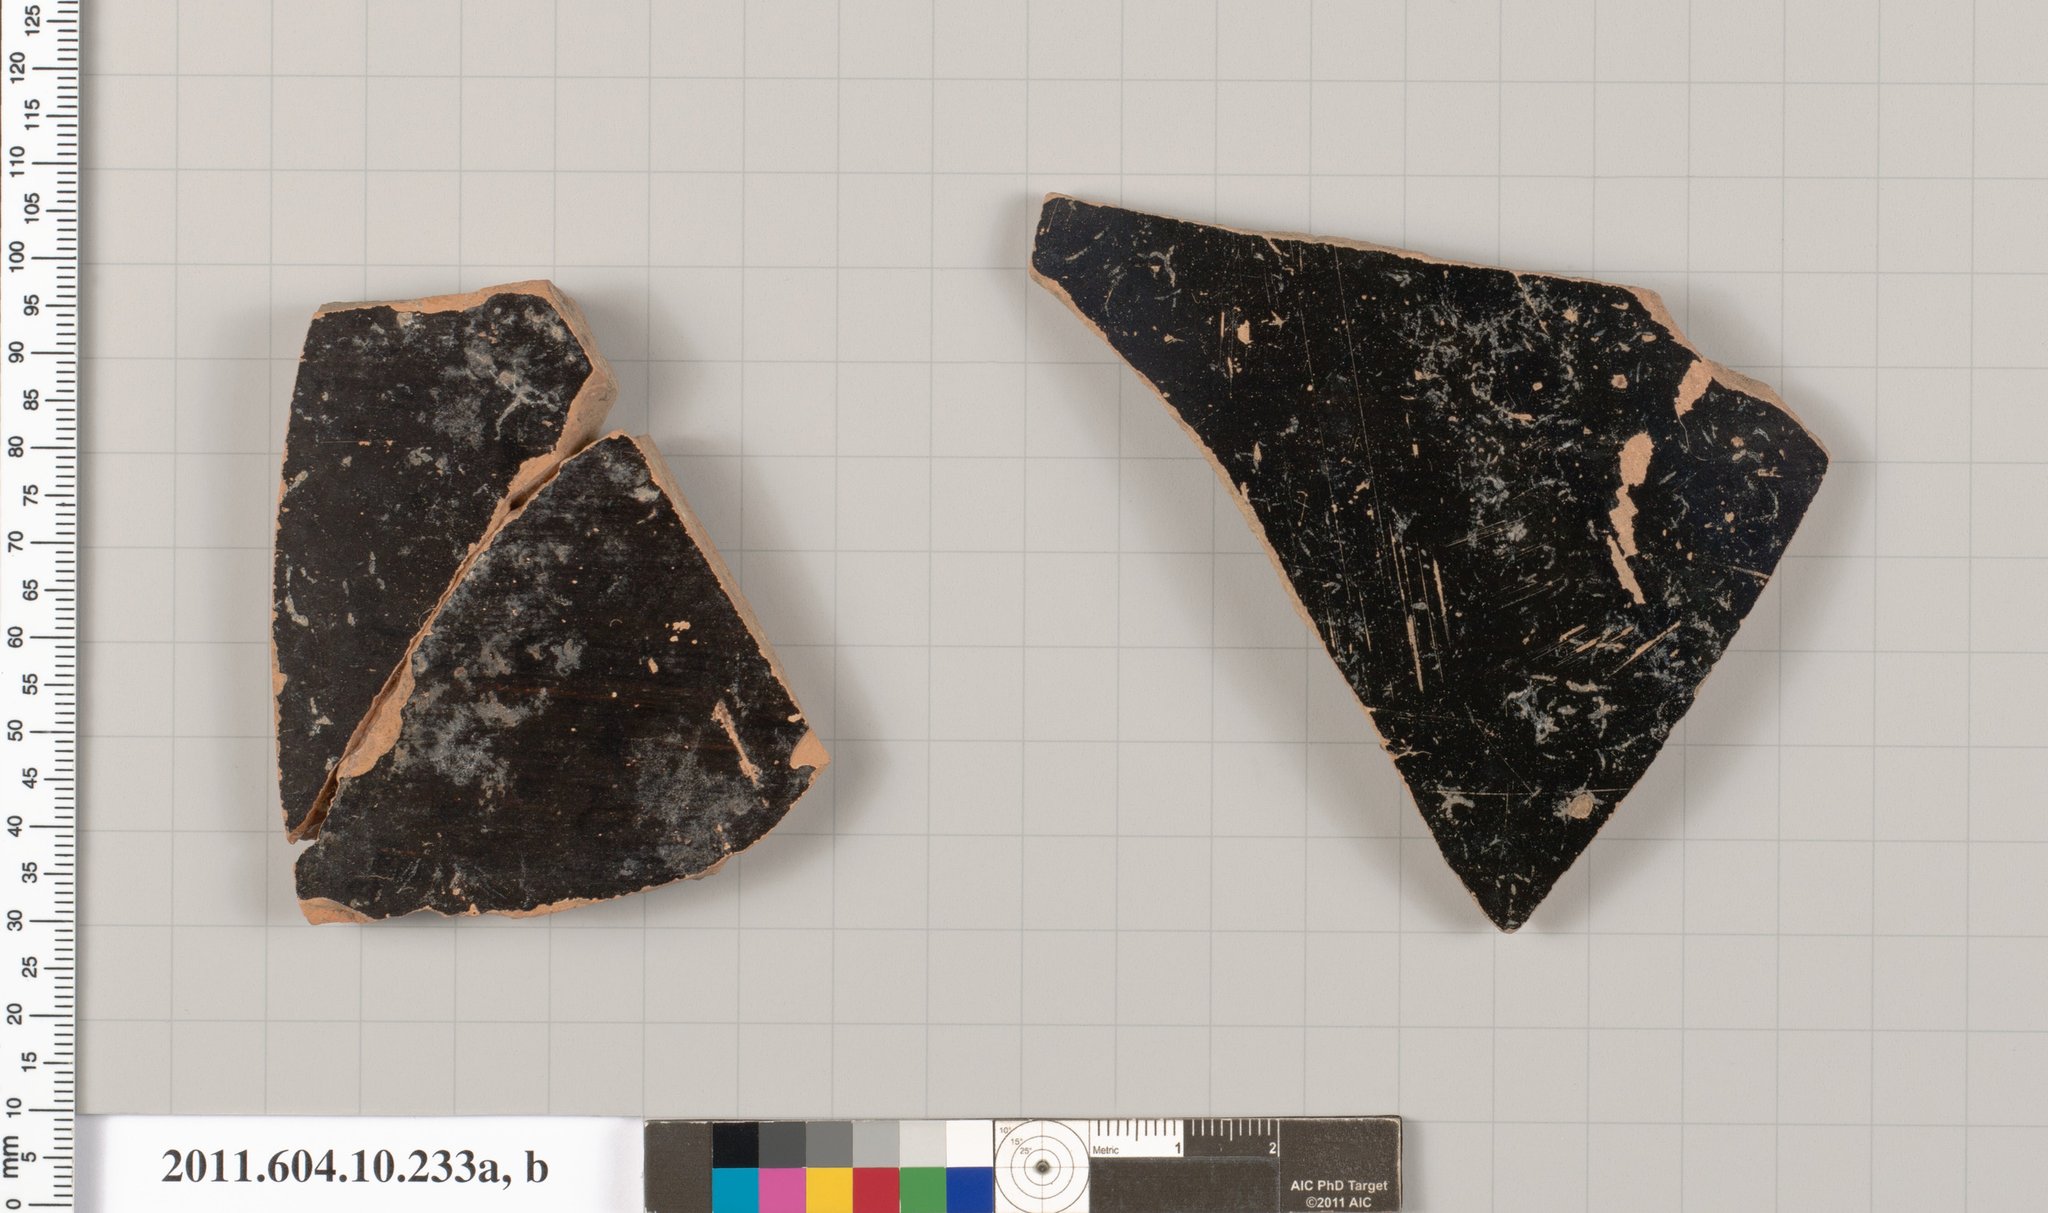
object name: krater fragment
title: Terracotta fragments of kraters (mixing bowls)?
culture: etruscan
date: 601-700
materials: terracotta